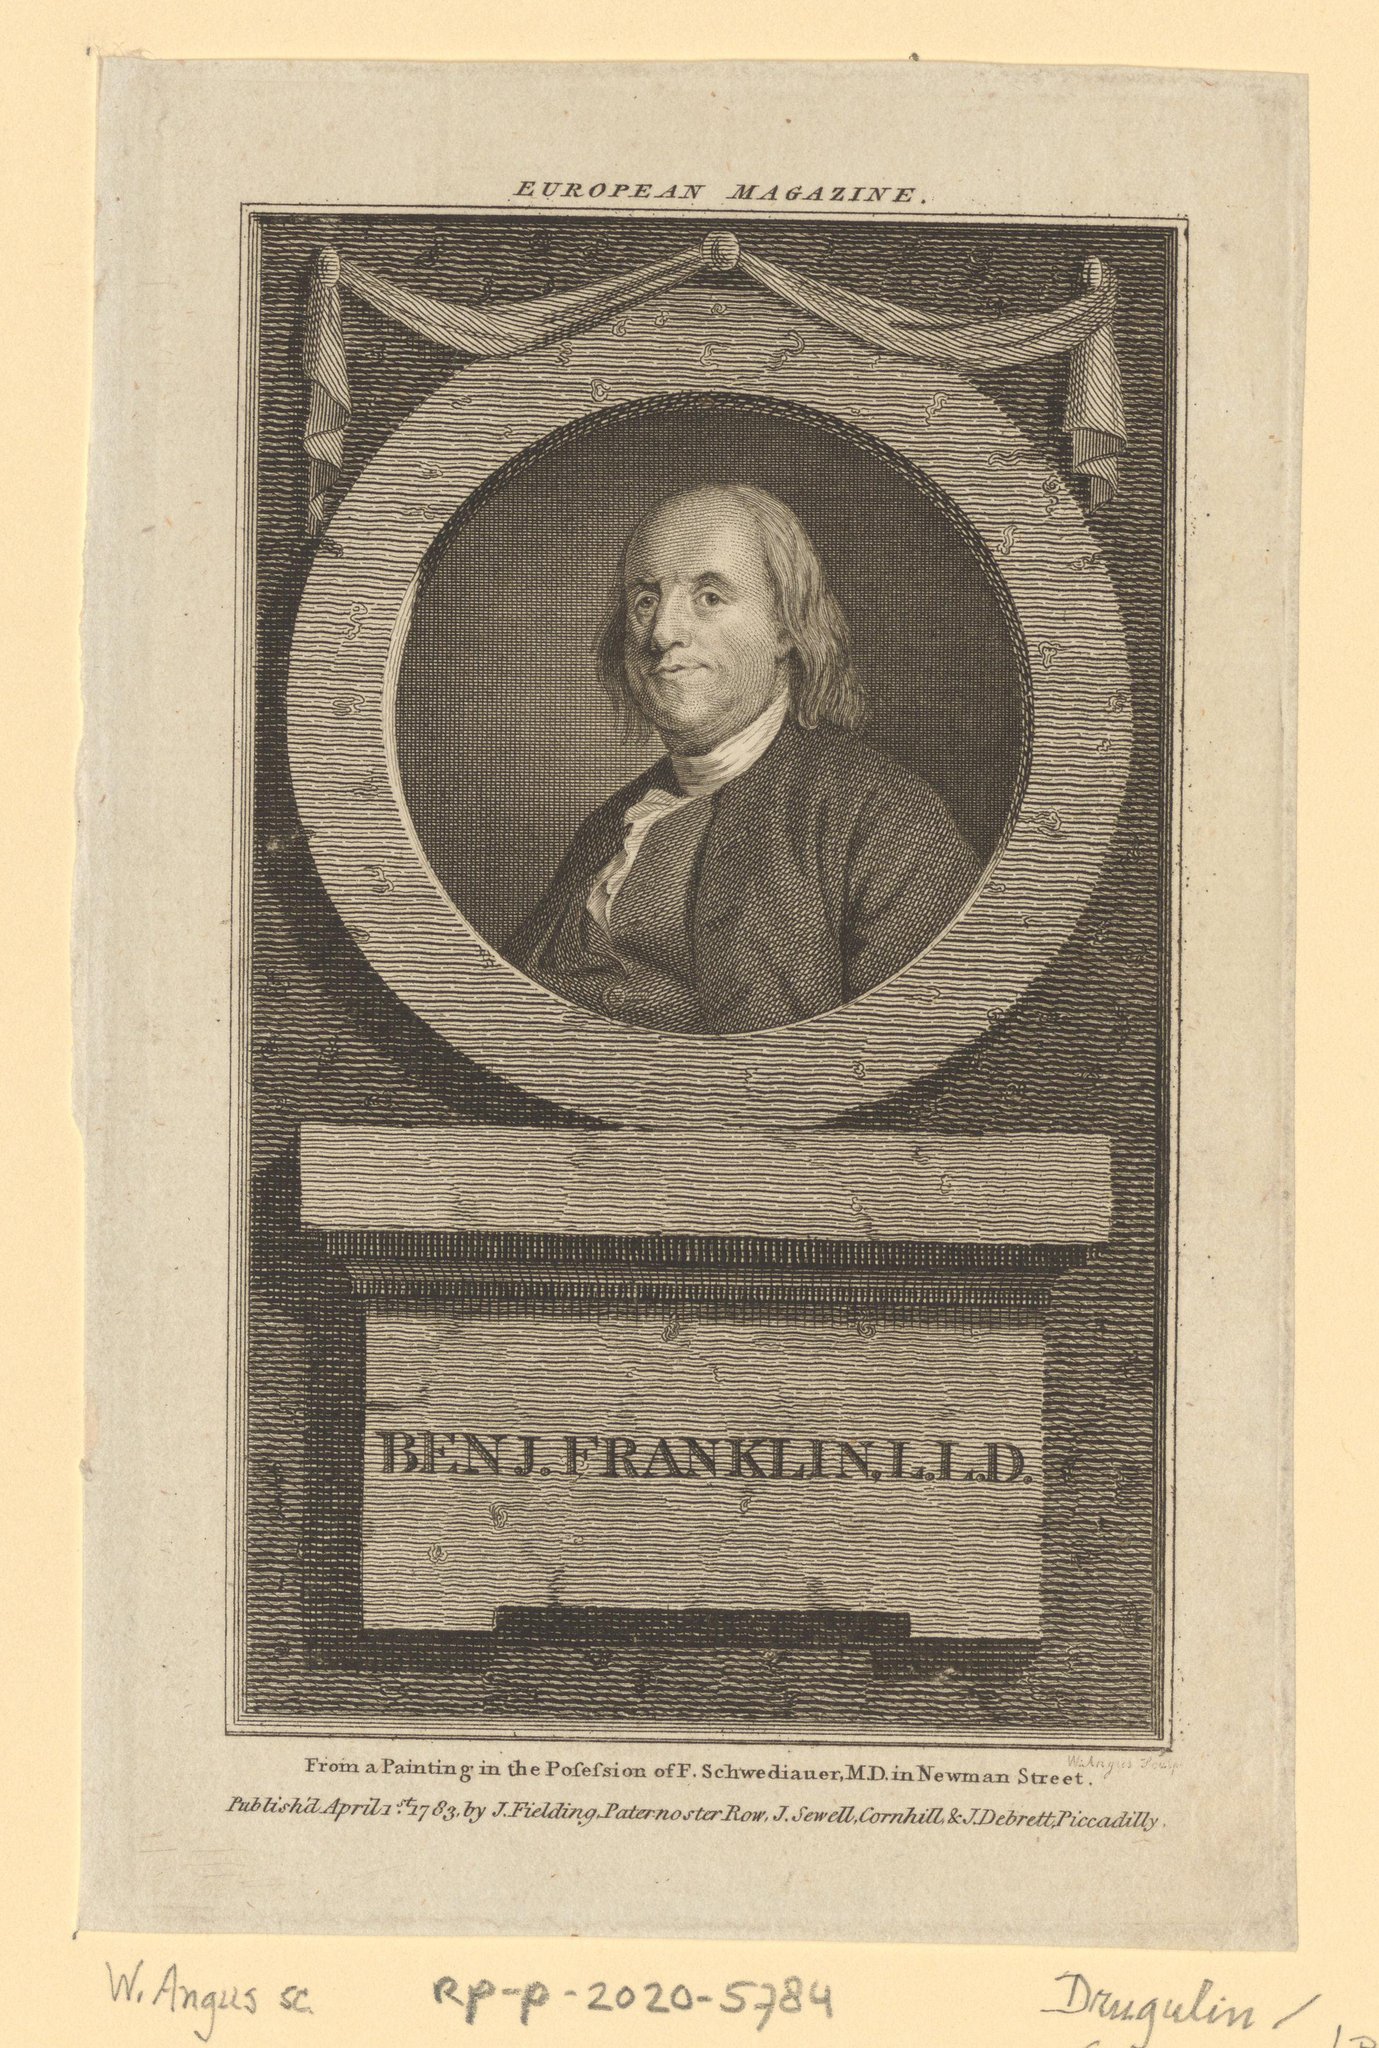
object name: print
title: Portret van Benjamin Franklin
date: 1704-1783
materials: paper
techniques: etching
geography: london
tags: physicist, historical persons, politician, e.g. party leader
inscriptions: date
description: Prent waarschijnlijk uit: The European Magazine, 1783.